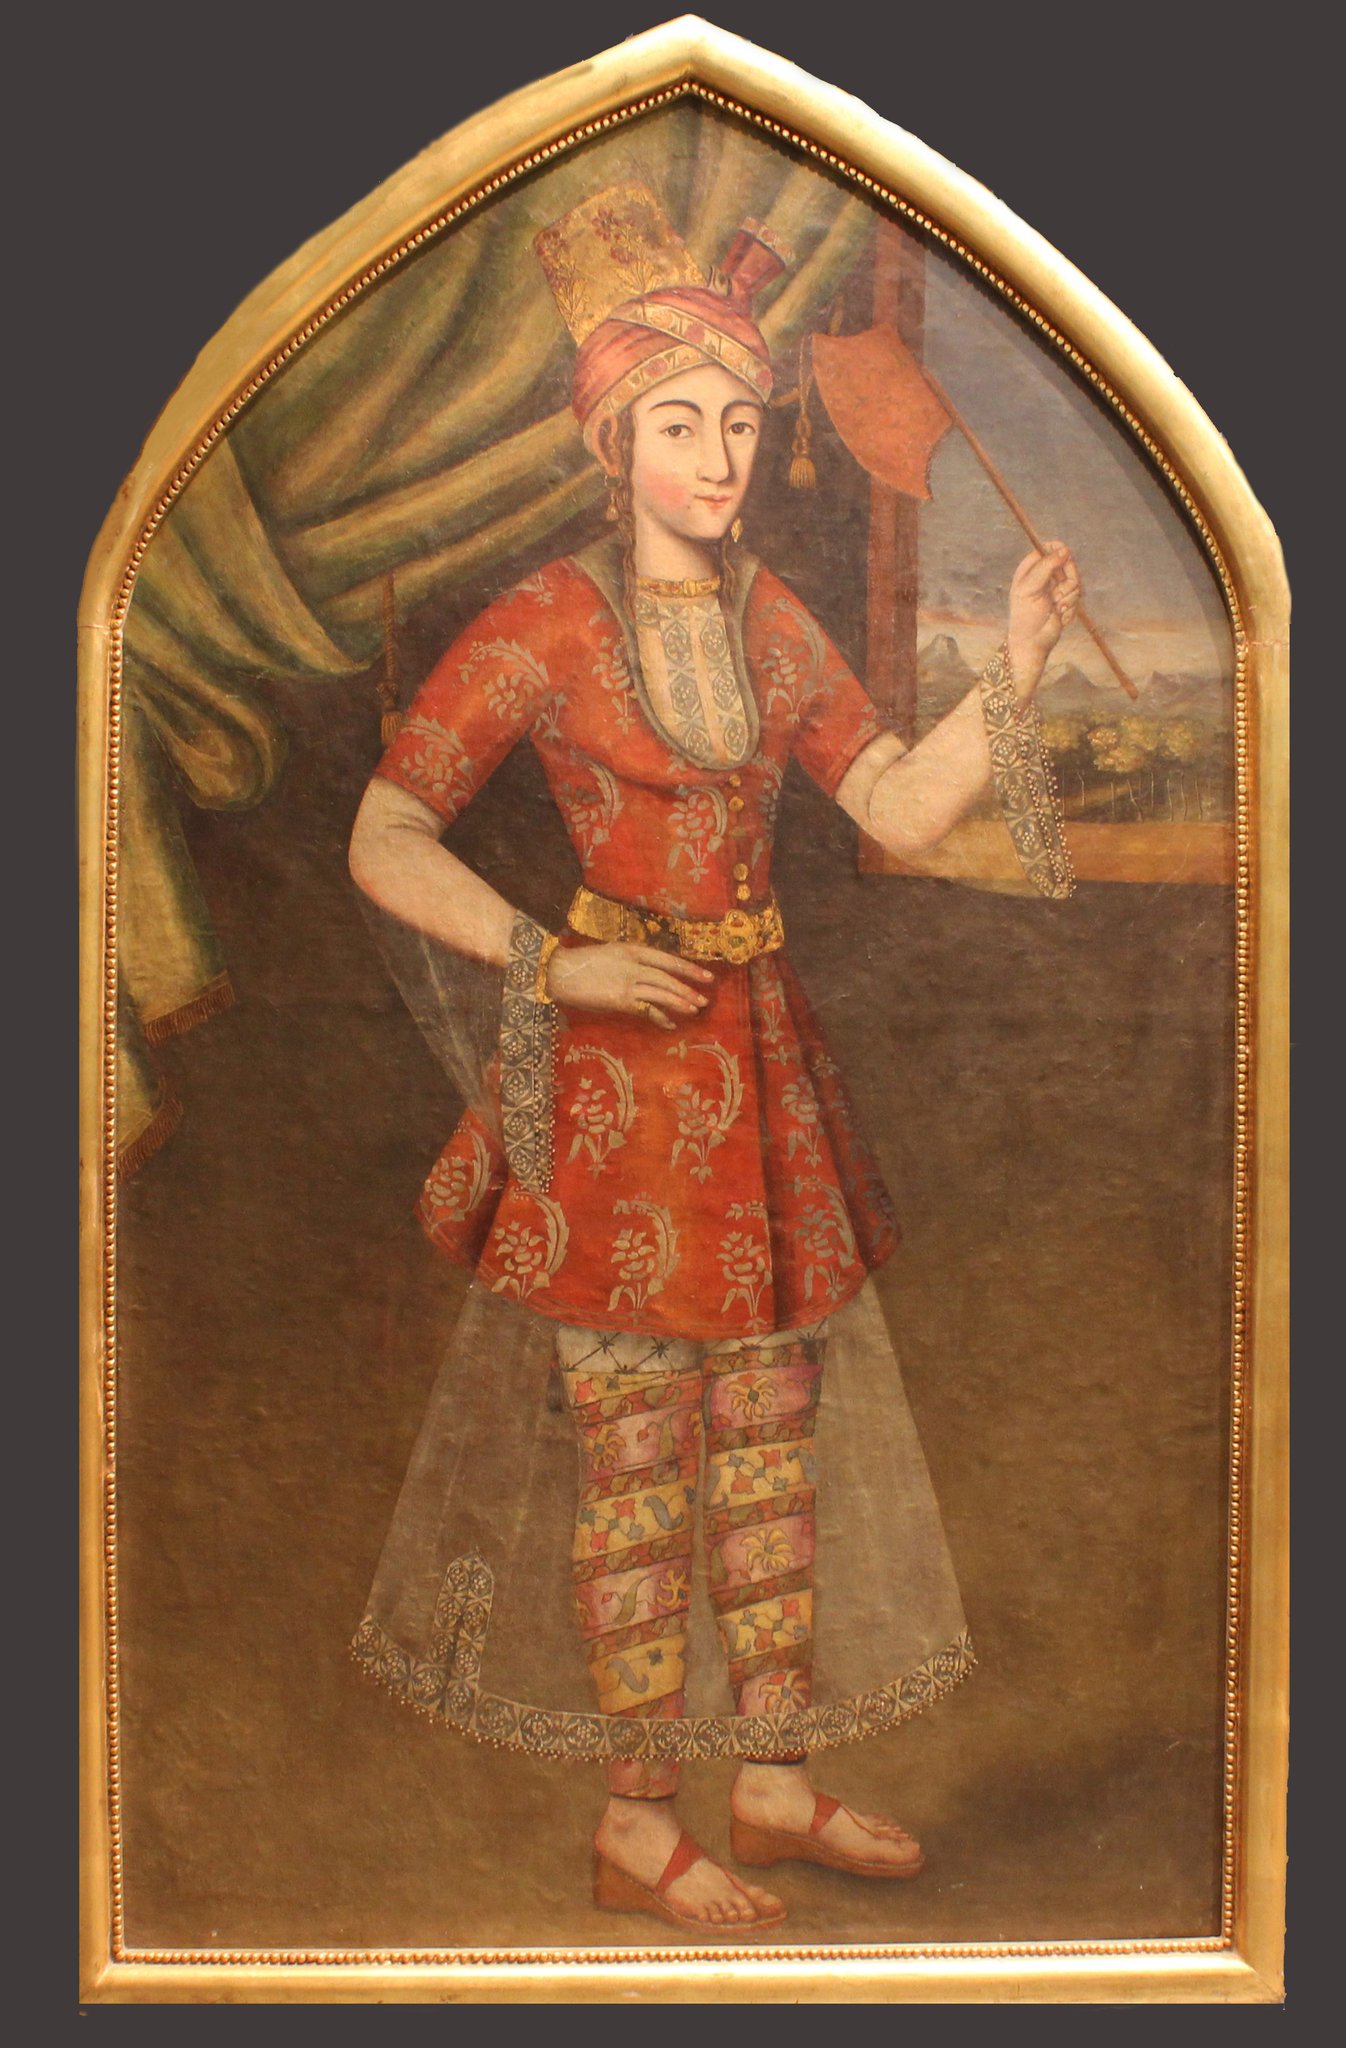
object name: painting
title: Lady with a Turkish Headdress (hotos)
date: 1634-1666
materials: canvas, oil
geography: iran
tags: fans,portraits,women